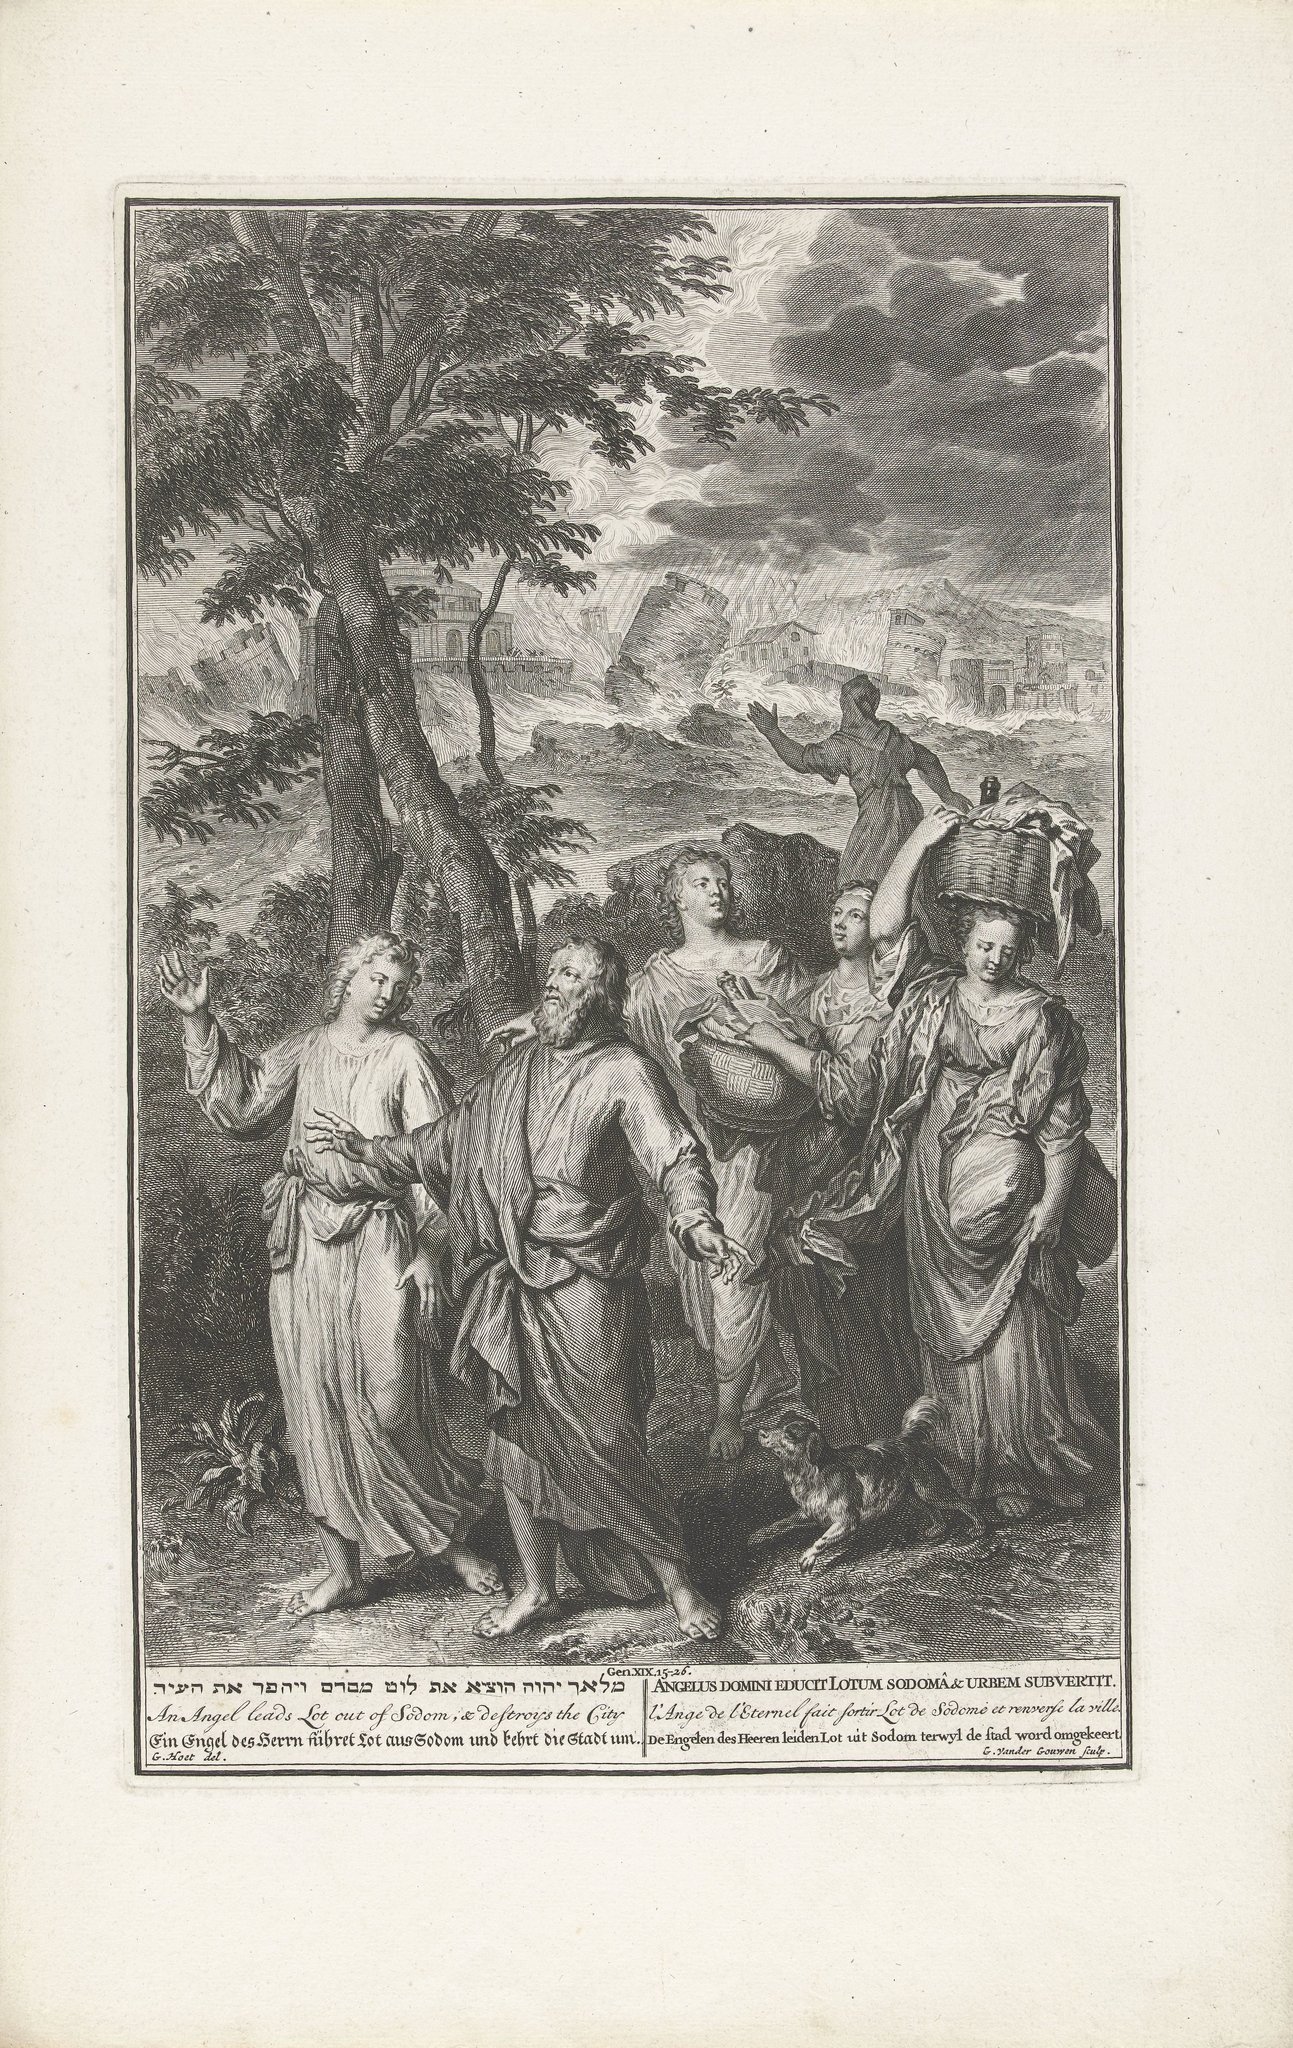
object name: print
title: Vlucht van Lot uit Sodom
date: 1728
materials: paper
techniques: engraving, etching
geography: the hague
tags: the destruction of sodom and gomorrah: lot and his family flee to zoar, carrying their belongings; an angel may be showing the way (genesis 19:24-29)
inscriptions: inscription: ‘utrechts Fundatie huijs’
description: Lot vlucht uit Sodom met zijn twee dochters, begeleid door twee engelen. Op de achtergrond het brandende Sodom en de vrouw van Lot als zoutpilaar (Gen. 19:15-26). De prent heeft een Hebreeuws, Latijns, Frans, Engels, Duits en Nederlands onderschrift.